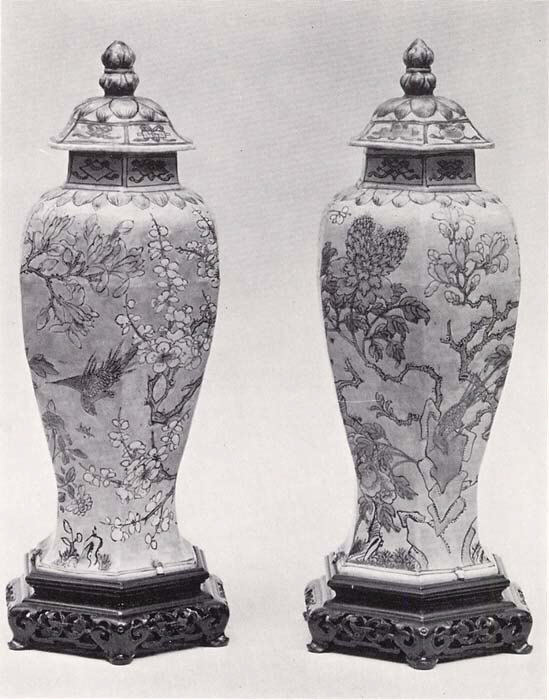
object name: vase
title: Vase (one of a pair)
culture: chinese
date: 1667-1733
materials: biscuit, enamel, porcelain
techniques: painting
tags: flowers,trees